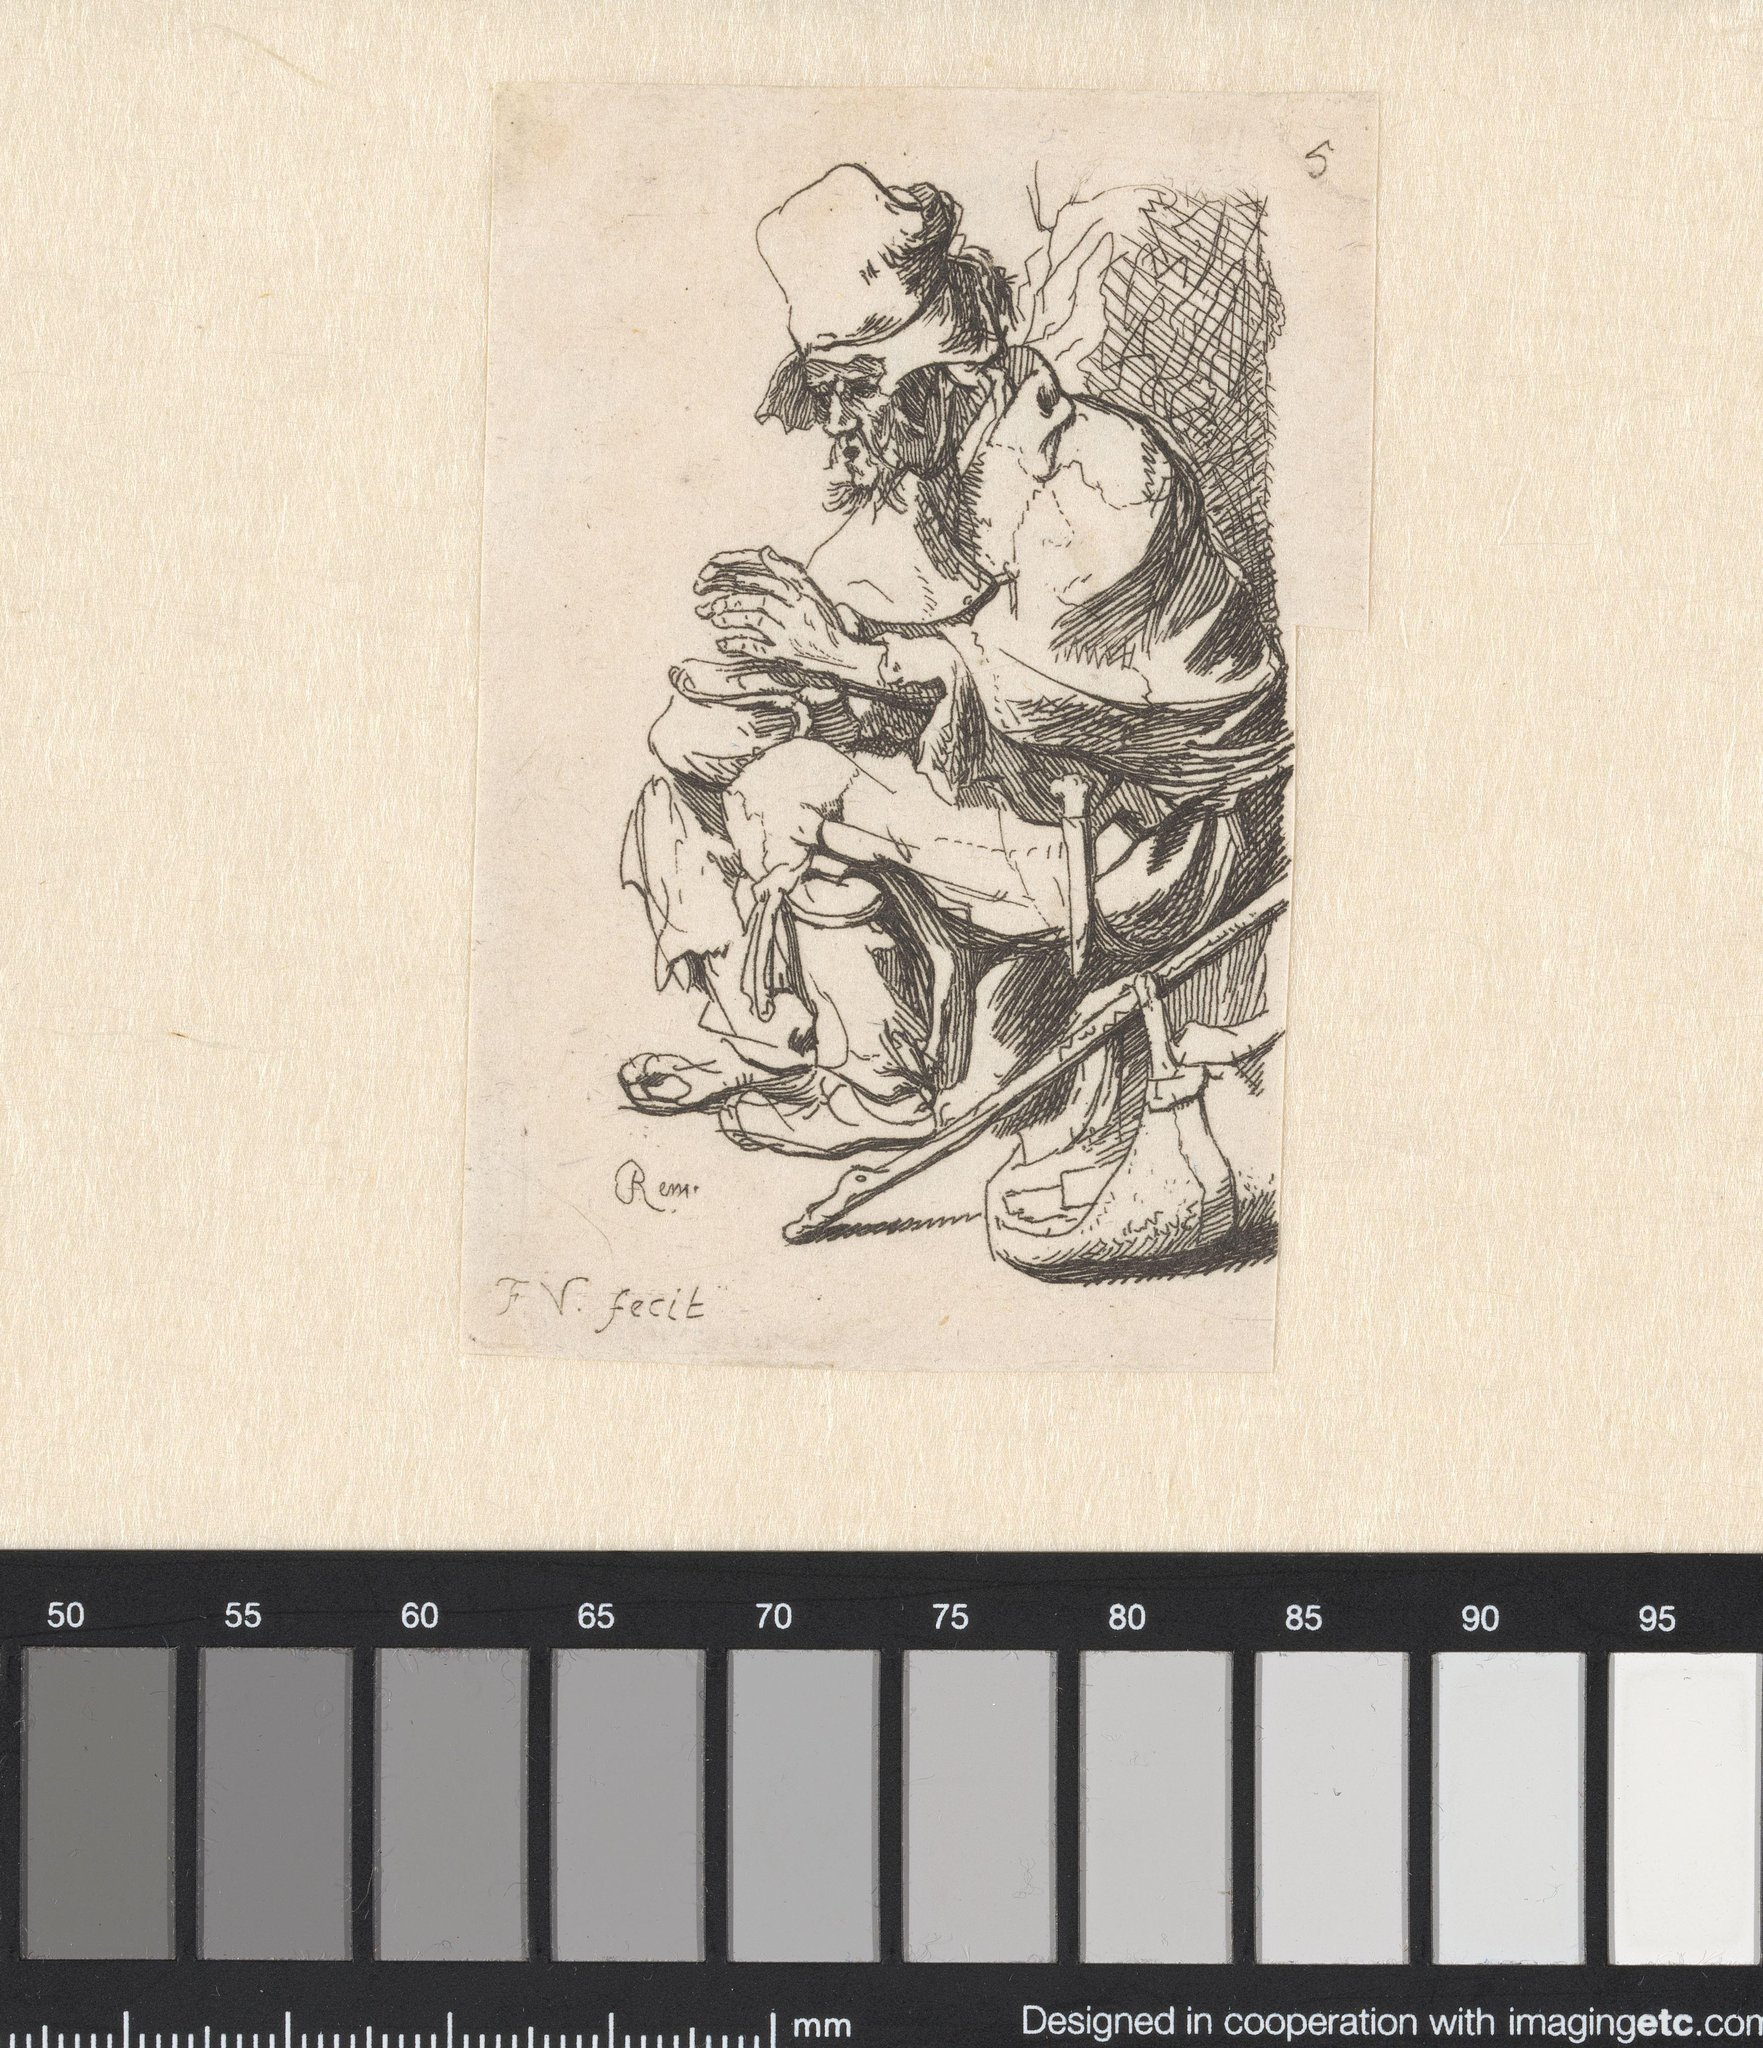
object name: print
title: Beggar seated warming his hands at a chafing dish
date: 1719-1780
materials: paper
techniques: etching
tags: beggar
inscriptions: collector's mark: Lugt 2228, collector's mark: Lugt 2760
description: Spiegelbeeldige kopie naar de gelijknamige prent van Rembrandt.